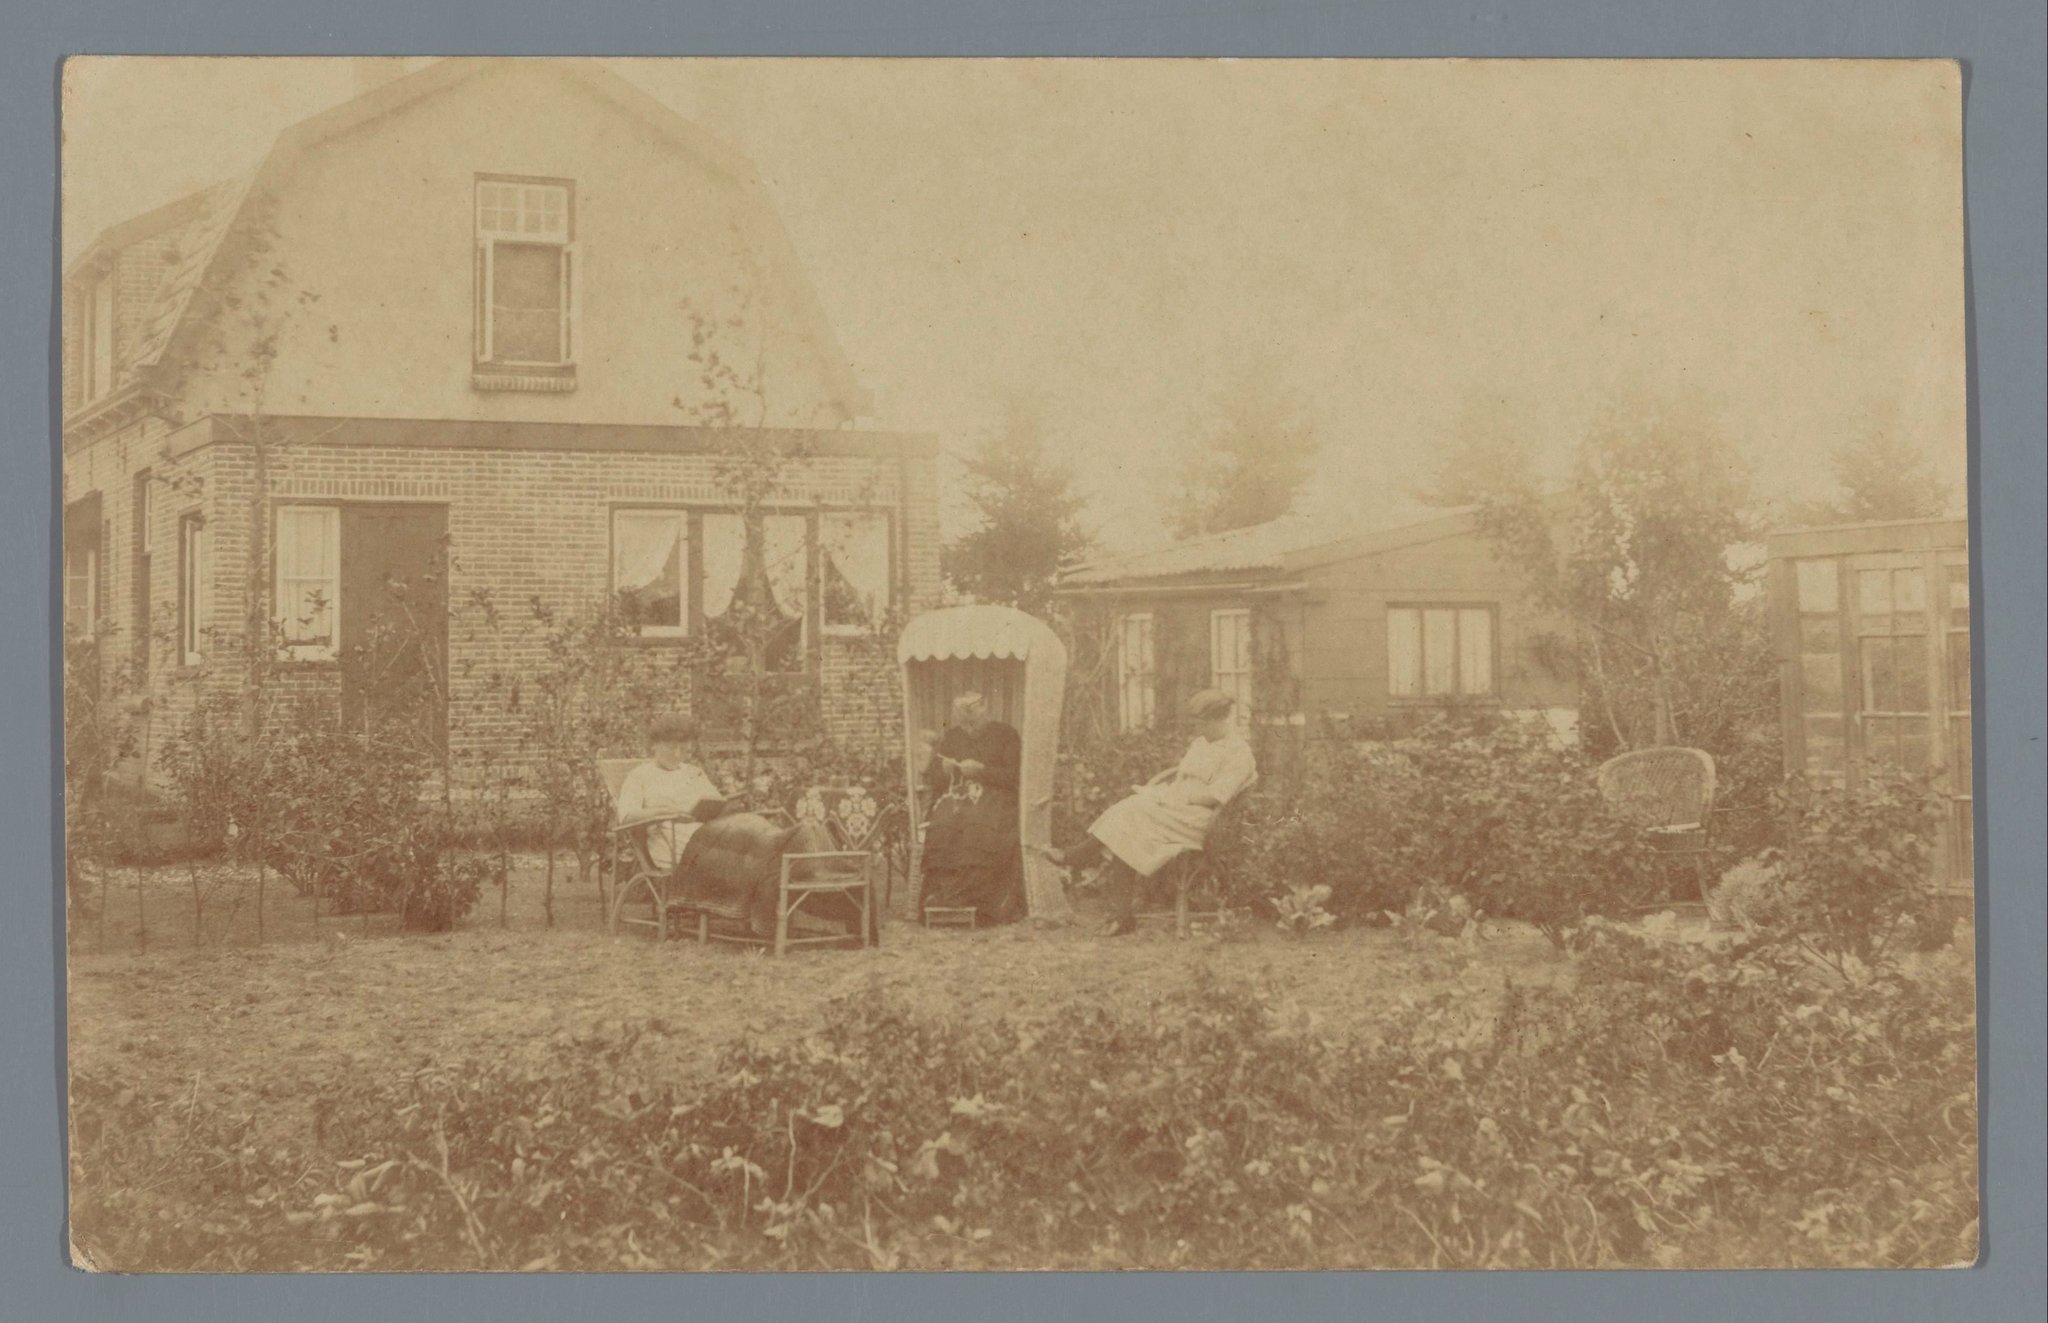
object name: photograph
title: Gezicht op een achtertuin met drie onbekende lezende vrouwen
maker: Anonymous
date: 1907-1915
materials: photographic support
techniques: gelatin silver print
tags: reading, façade (of house or building), backyard